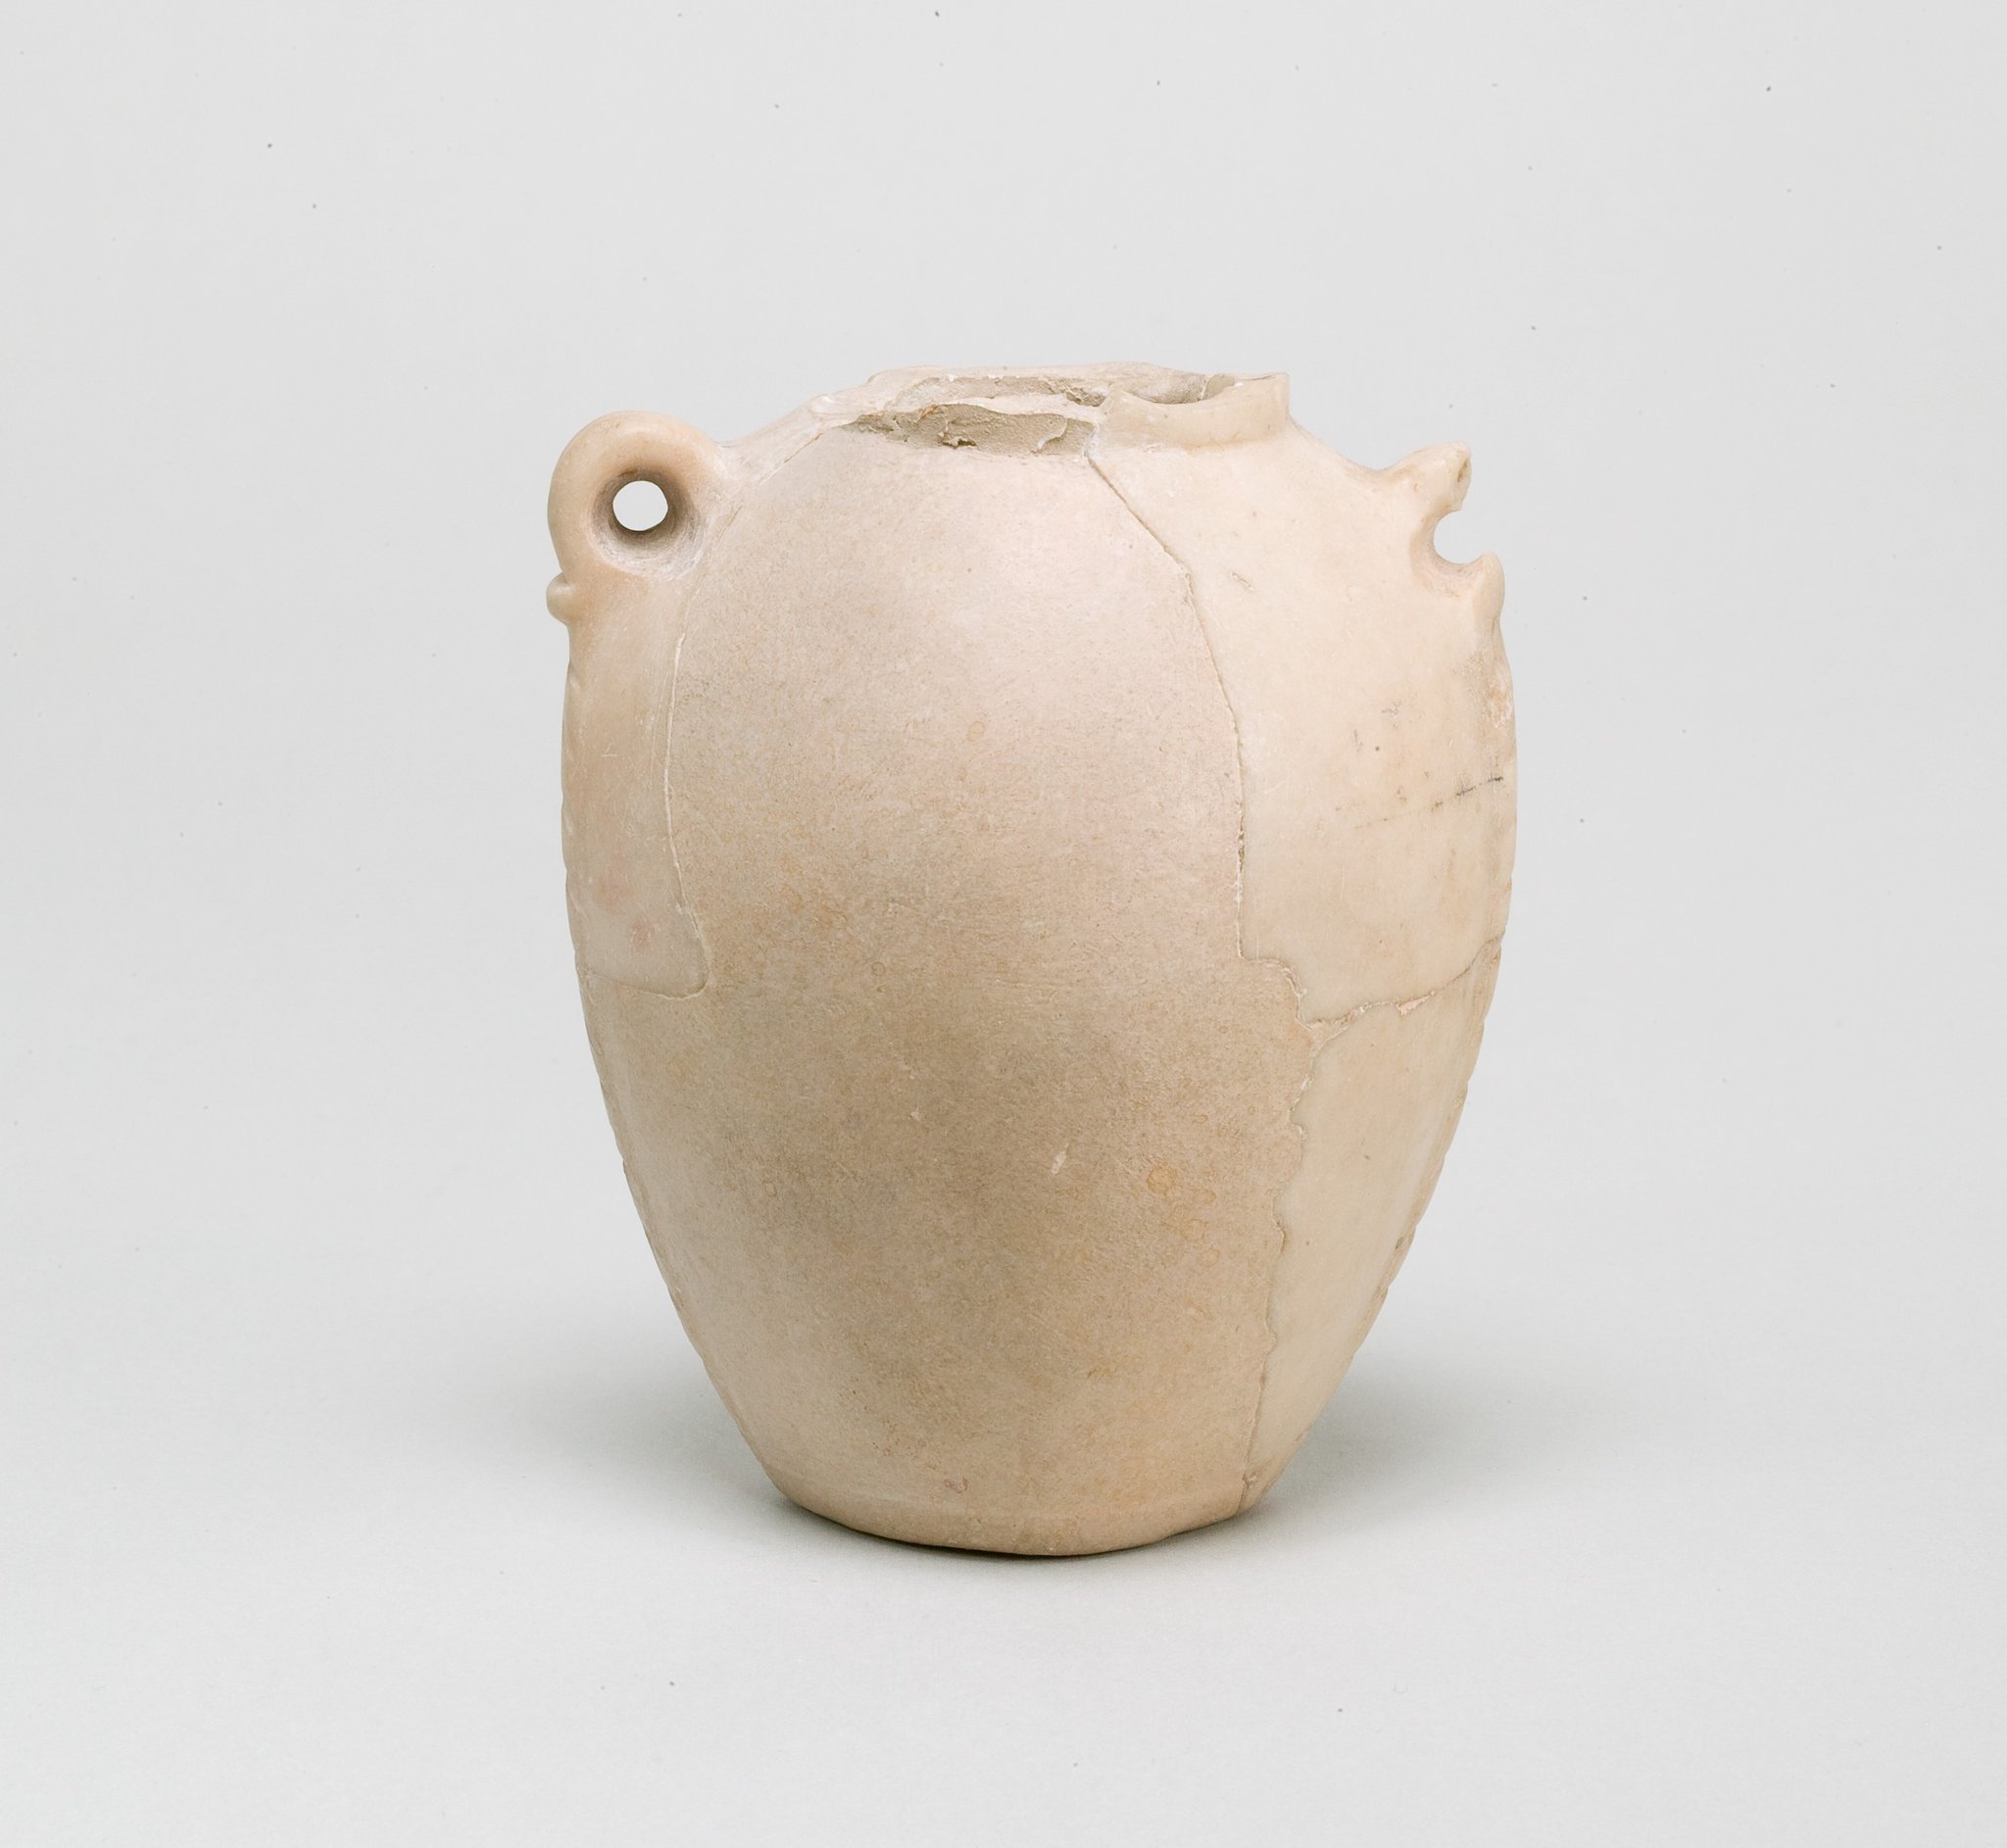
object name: jar, lug handle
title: Jar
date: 1390-1352 BCE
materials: limestone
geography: egypt